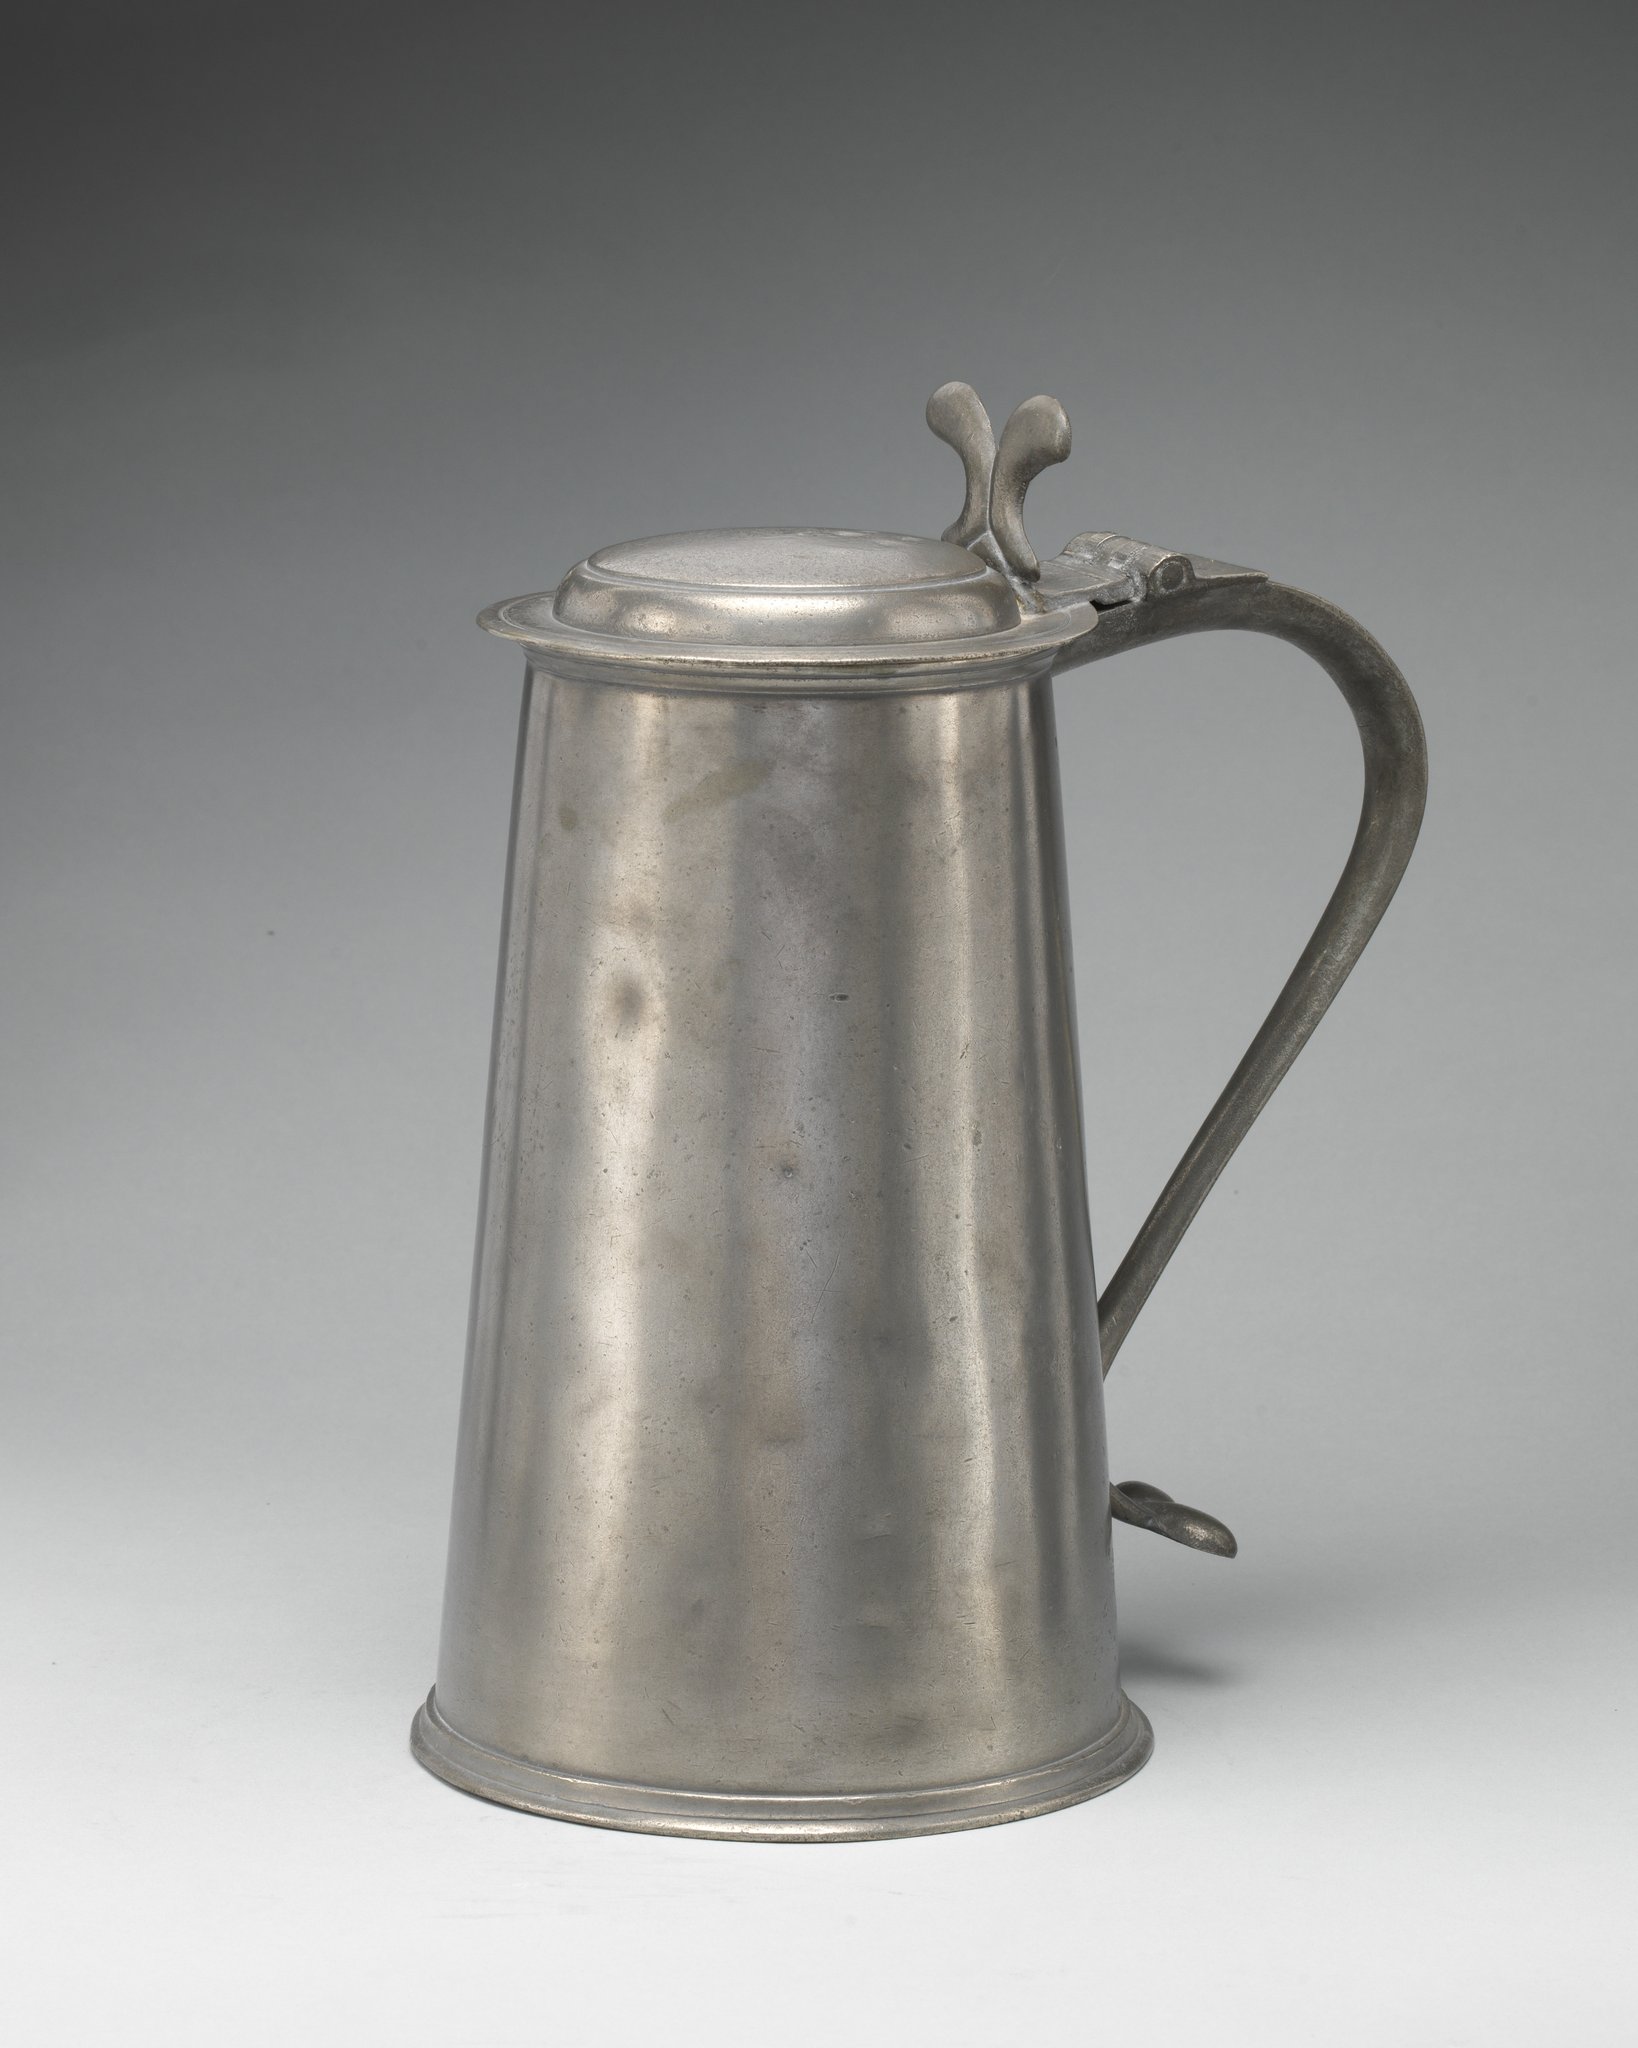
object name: flagon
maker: william wood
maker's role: maker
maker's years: 1700-1730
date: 1702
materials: pewter